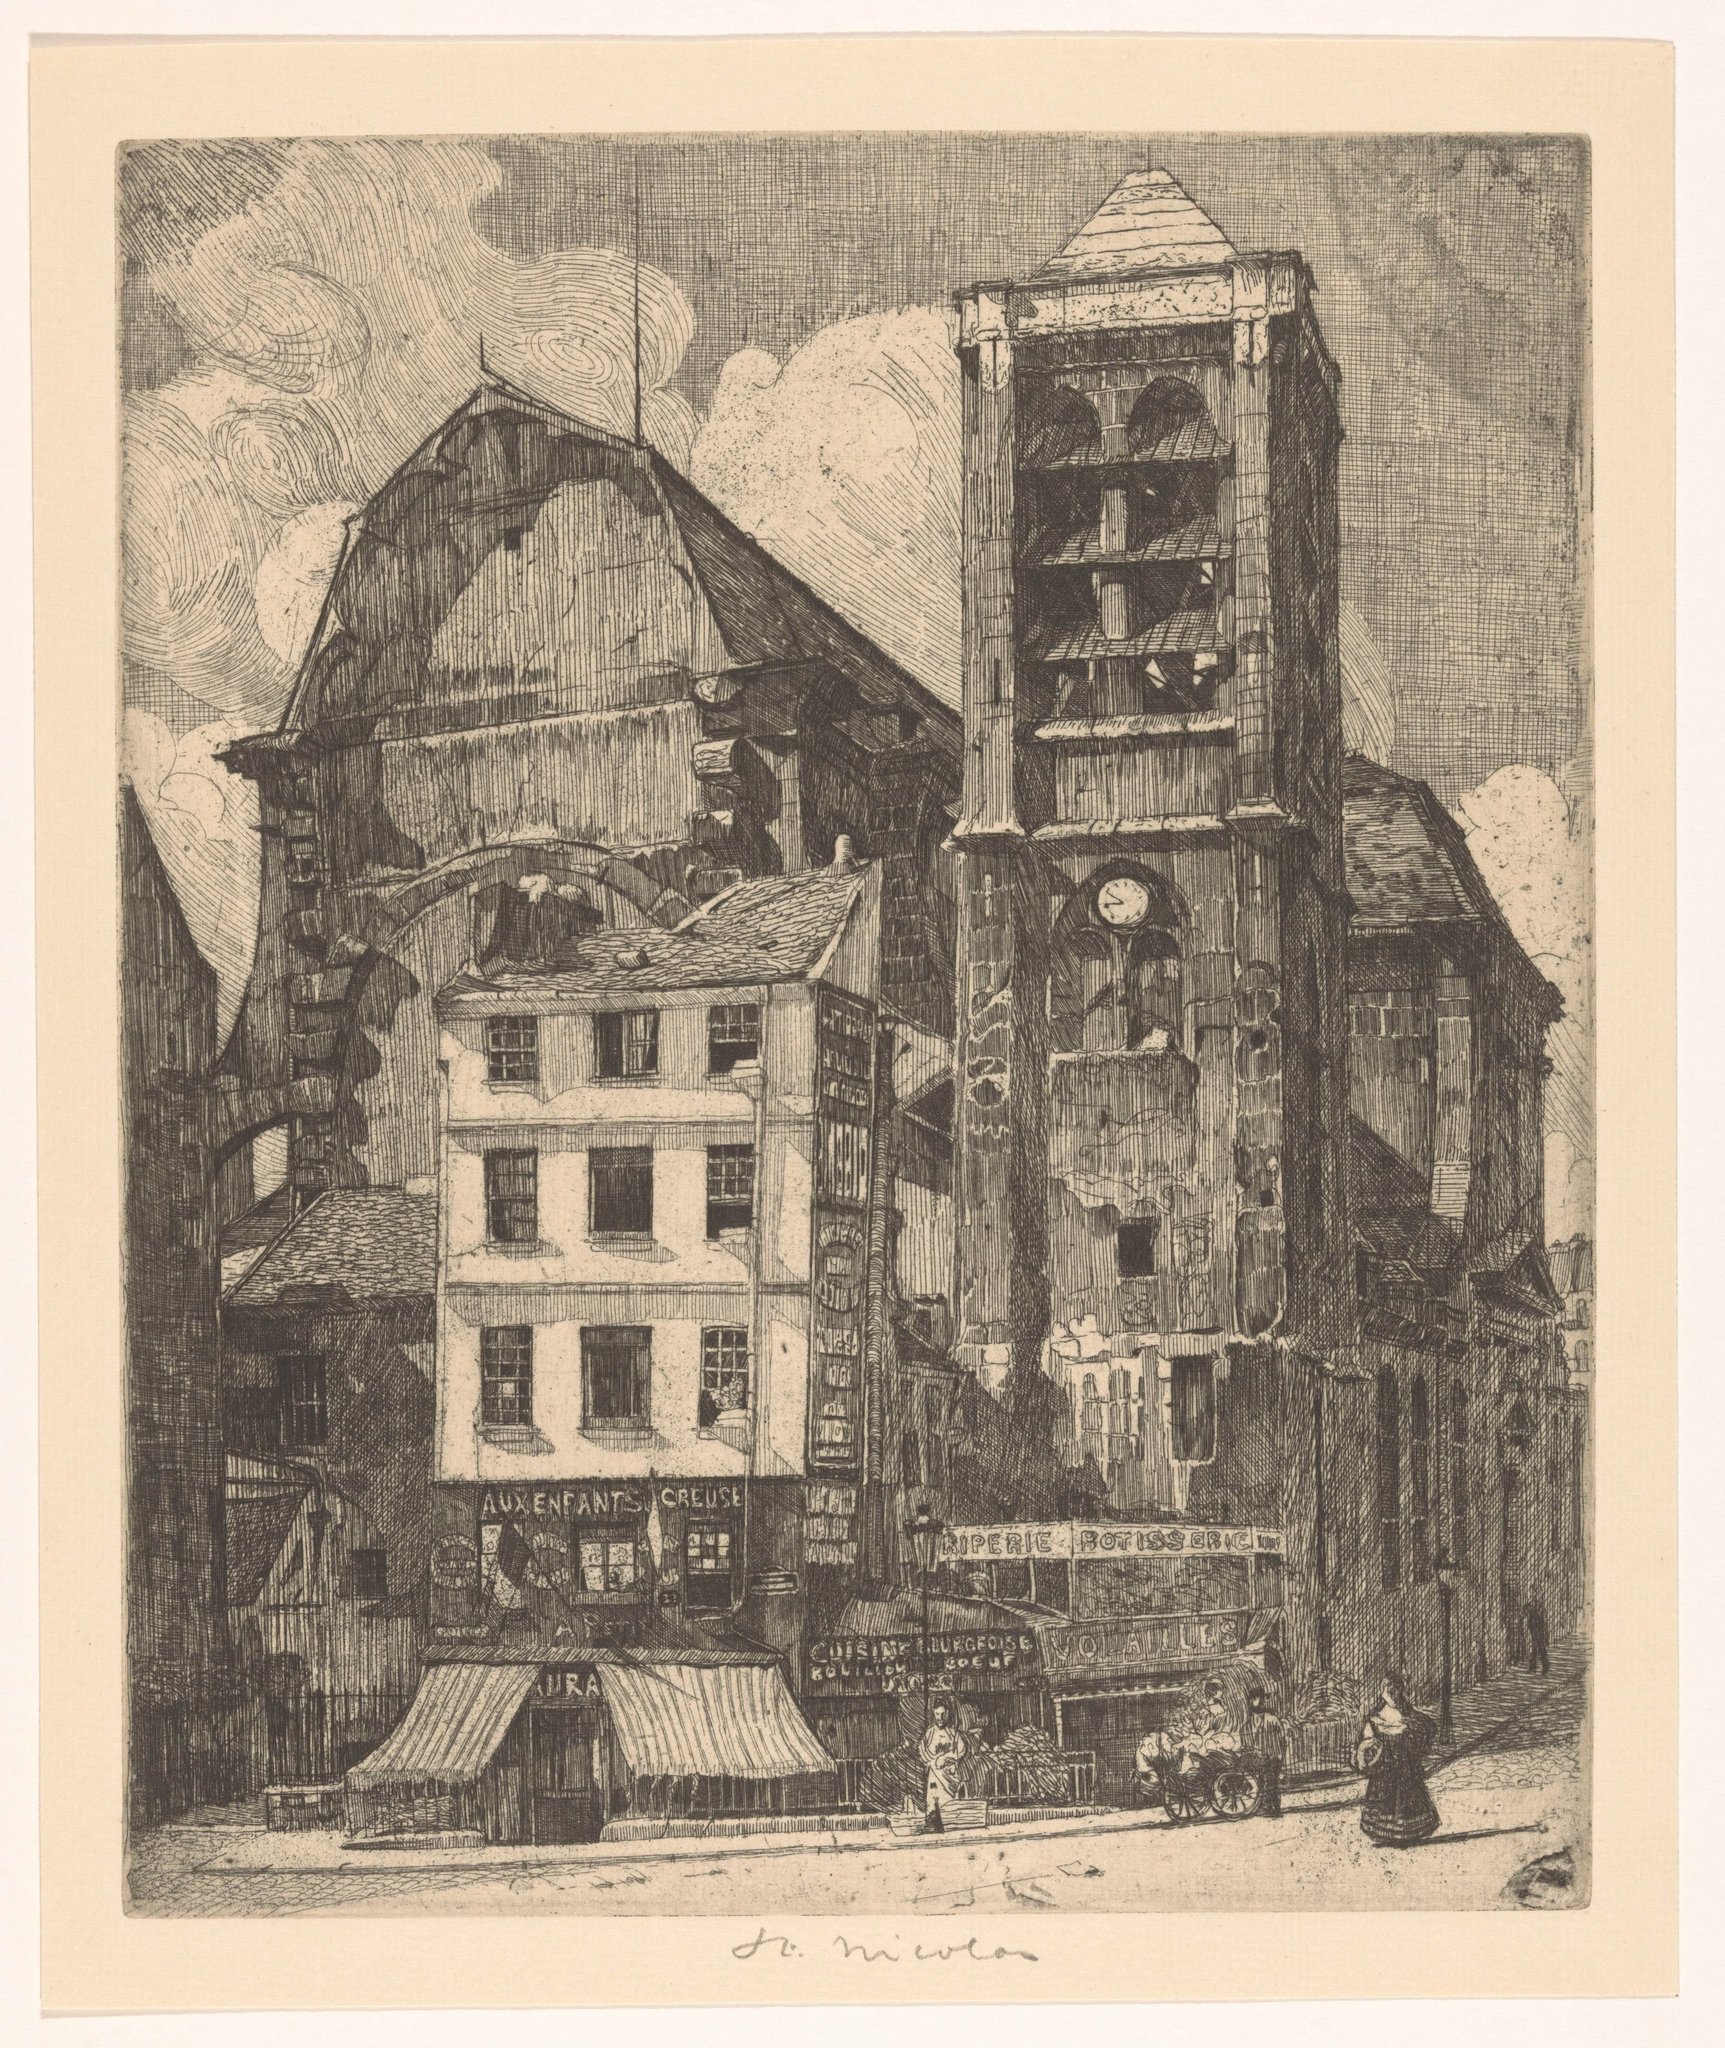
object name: print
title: Saint Nicolas du Chardonnet in Parijs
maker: martin monnickendam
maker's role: draughtsman, painter, print maker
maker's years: 1874-1943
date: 1896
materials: paper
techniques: etching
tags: shop, store, church (exterior), paris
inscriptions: collector's mark: Lugt 2228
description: Rechts de kerktoren. Links een gebouw met luifels en reclame op de gevel.